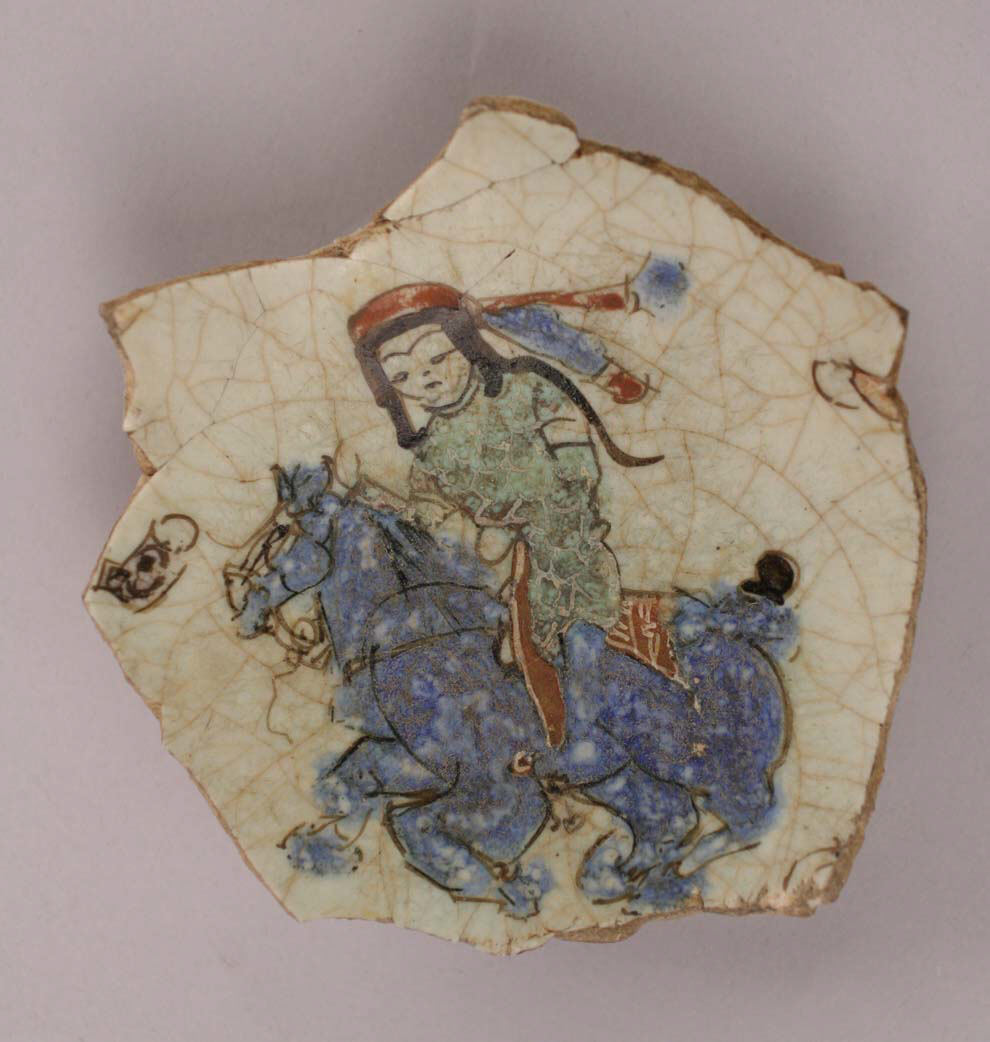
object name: fragment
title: Fragment of a Bowl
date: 1101-1300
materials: stonepaste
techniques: overglaze, painting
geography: iran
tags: human figures,horses